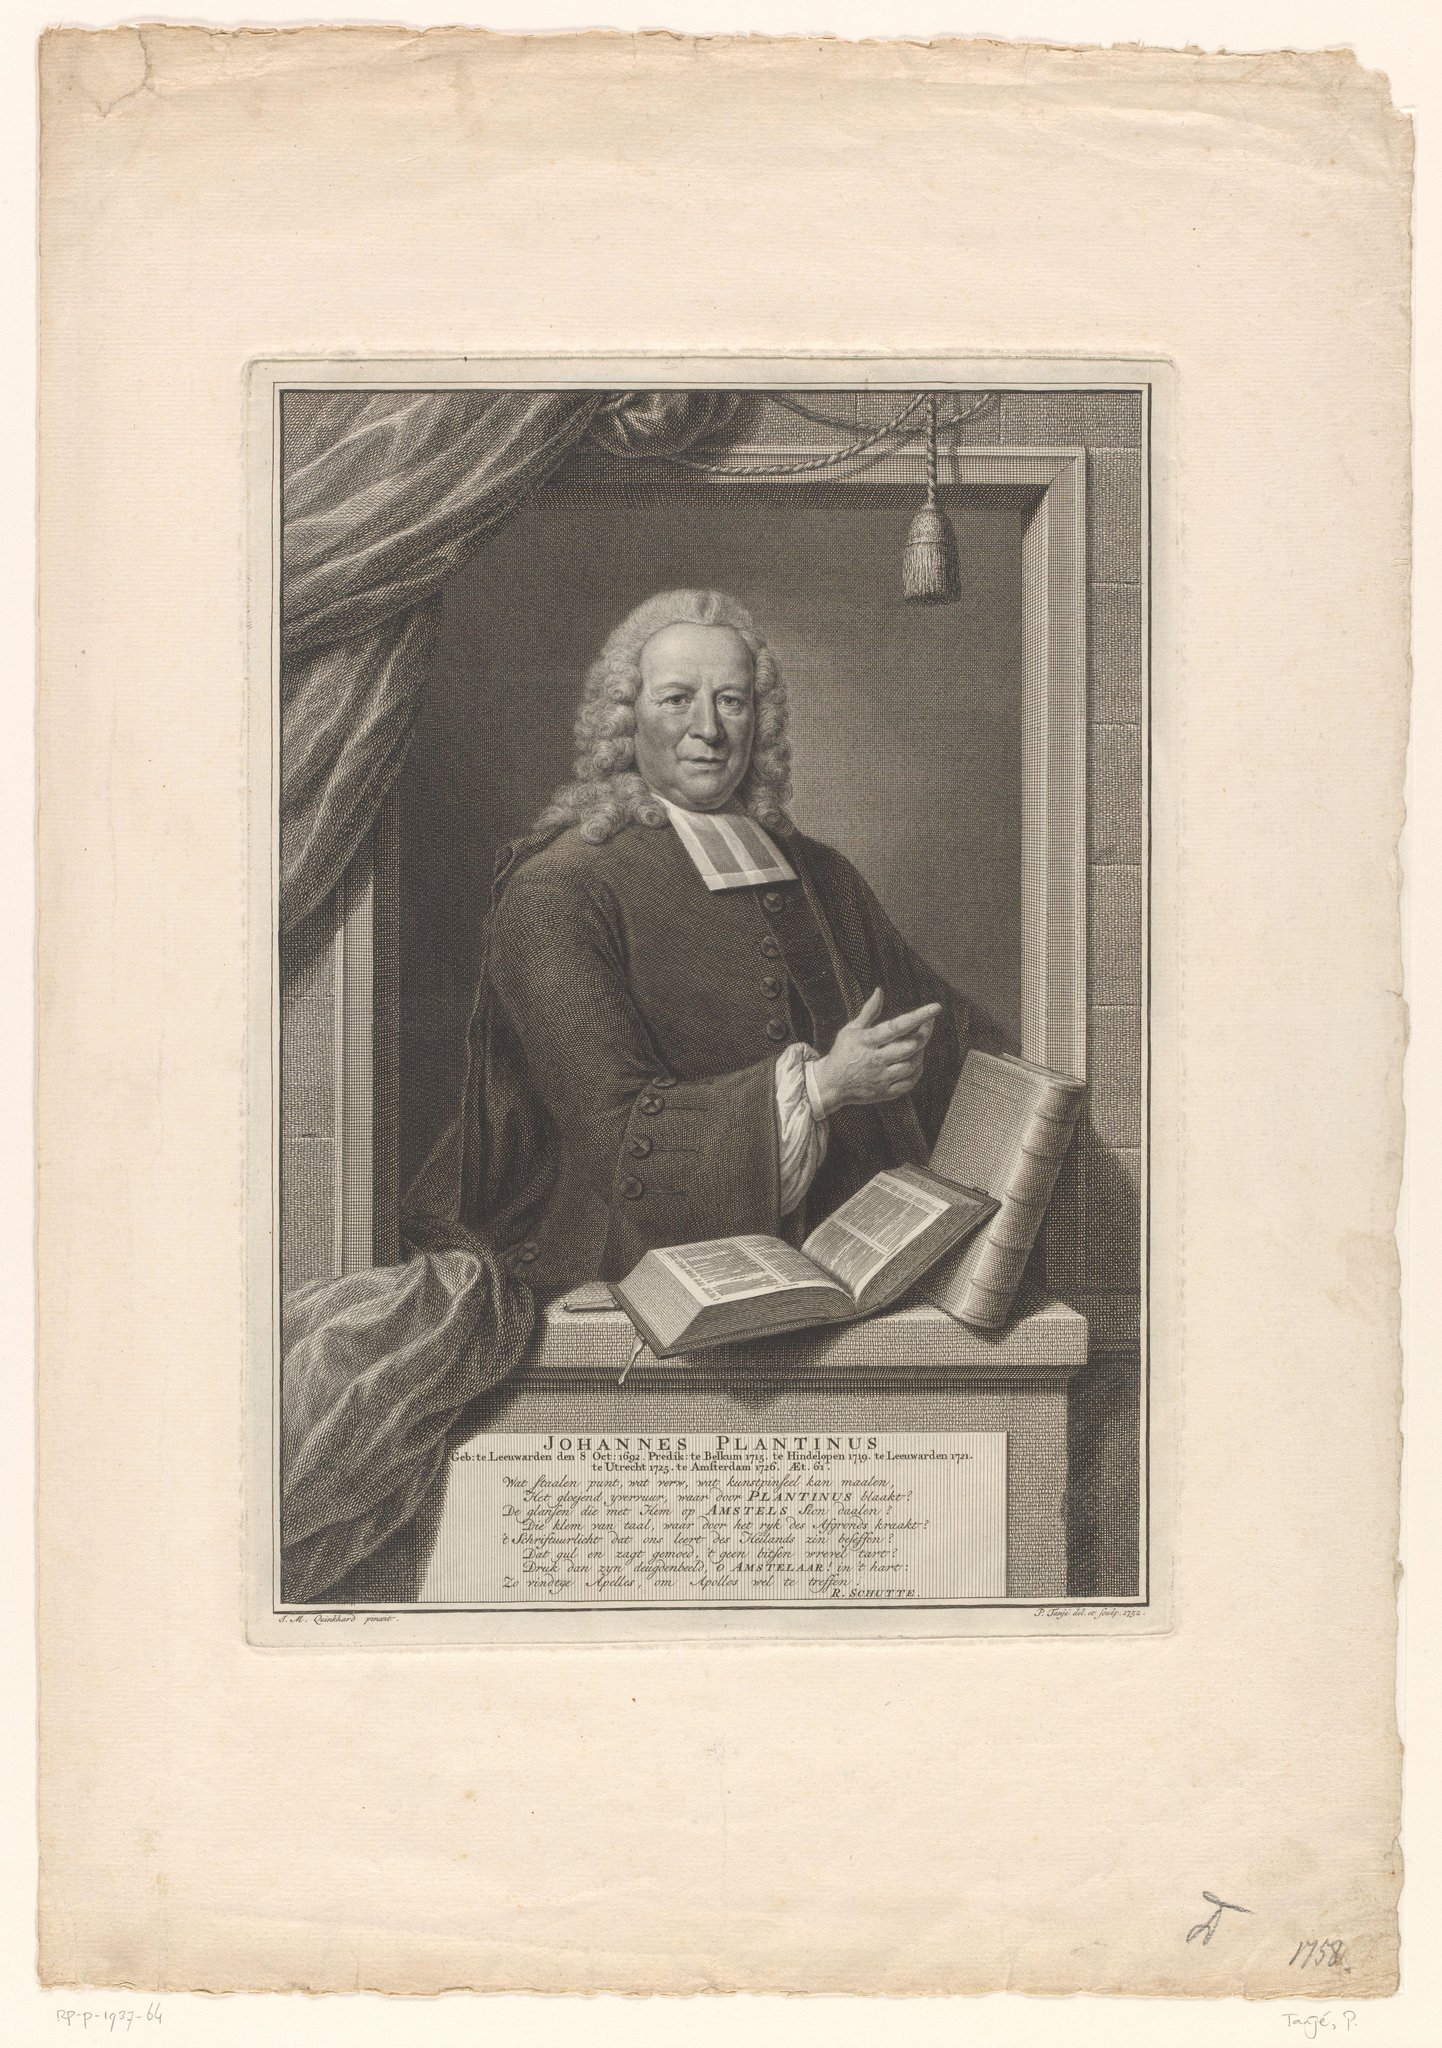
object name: print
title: Portret van Johannes Plantinus op 61-jarige leeftijd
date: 1752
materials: paper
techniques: engraving, etching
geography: amsterdam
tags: amsterdam, historical persons, the bible as a book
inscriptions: date